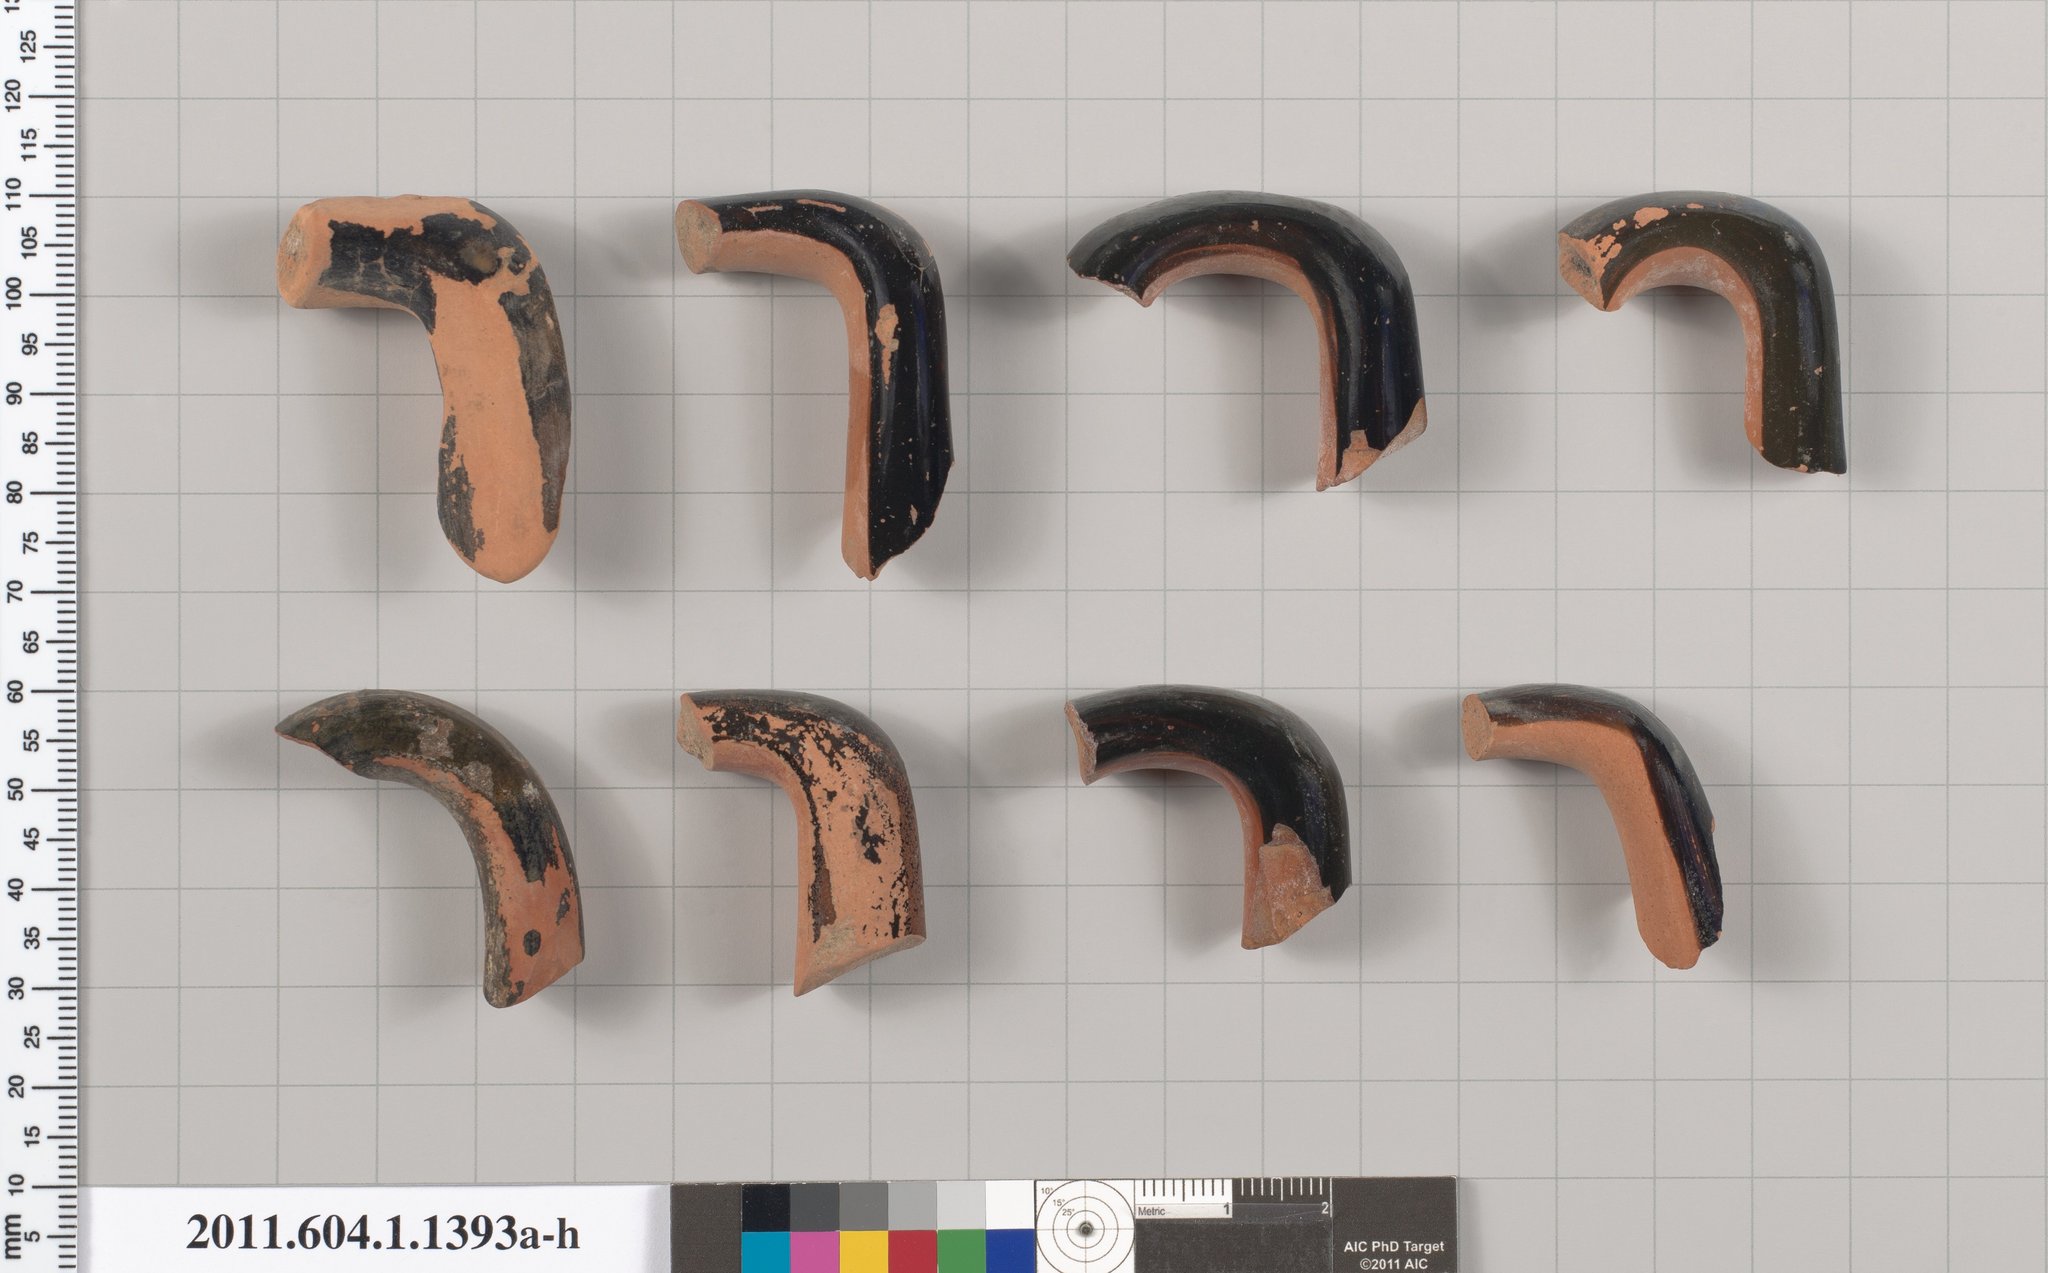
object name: kylix fragment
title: Terracotta fragments of kylikes (drinking cups)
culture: greek, attic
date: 500-401 BCE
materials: terracotta